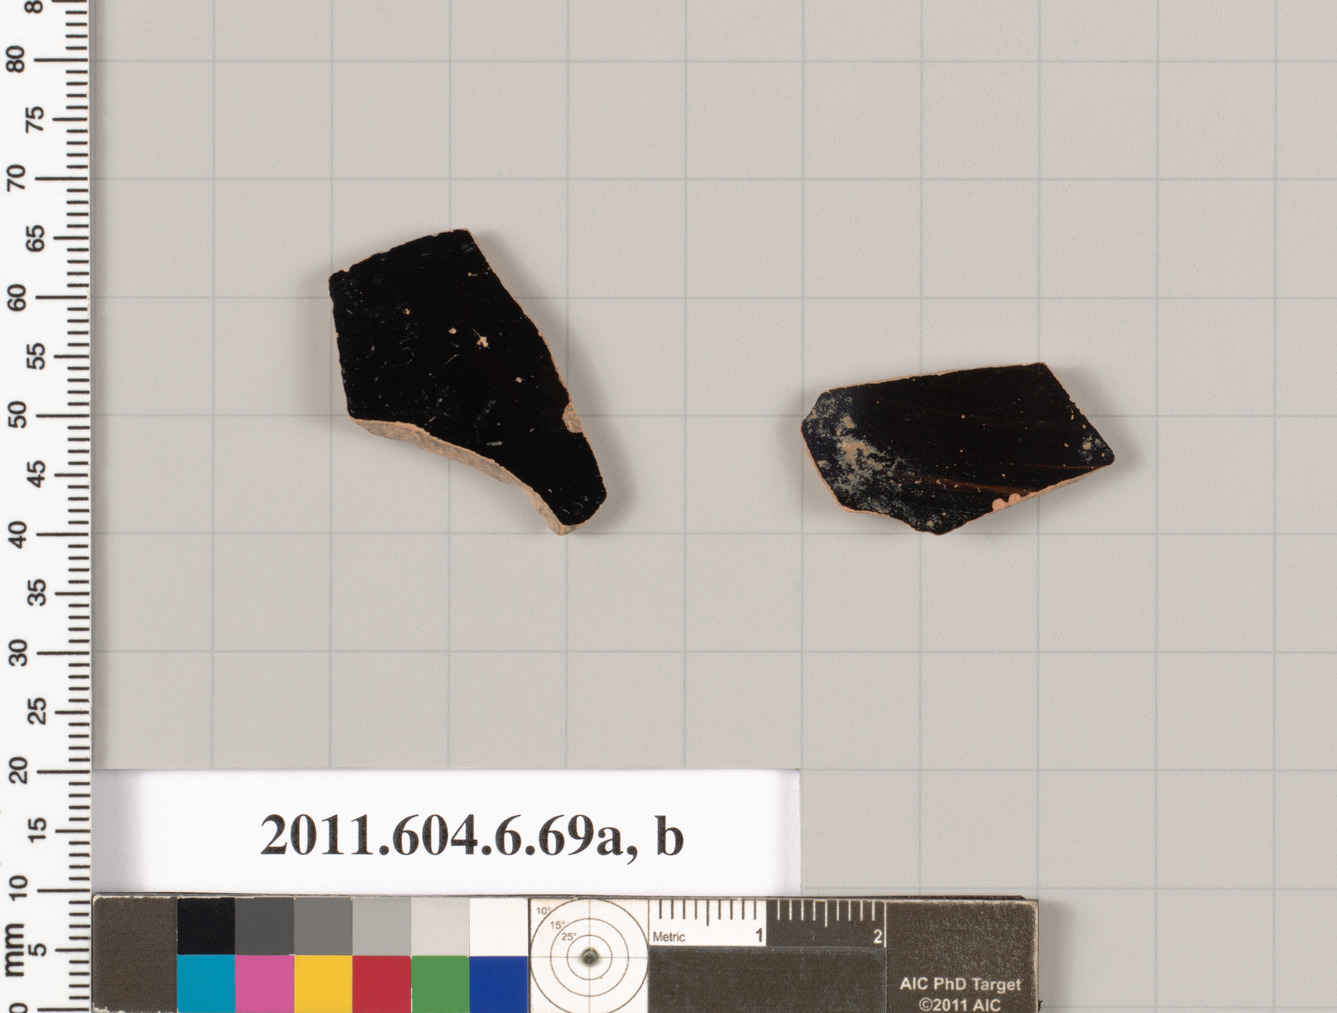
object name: undetermined open shape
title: Terracotta fragments of open shapes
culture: greek, attic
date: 600-401 BCE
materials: terracotta